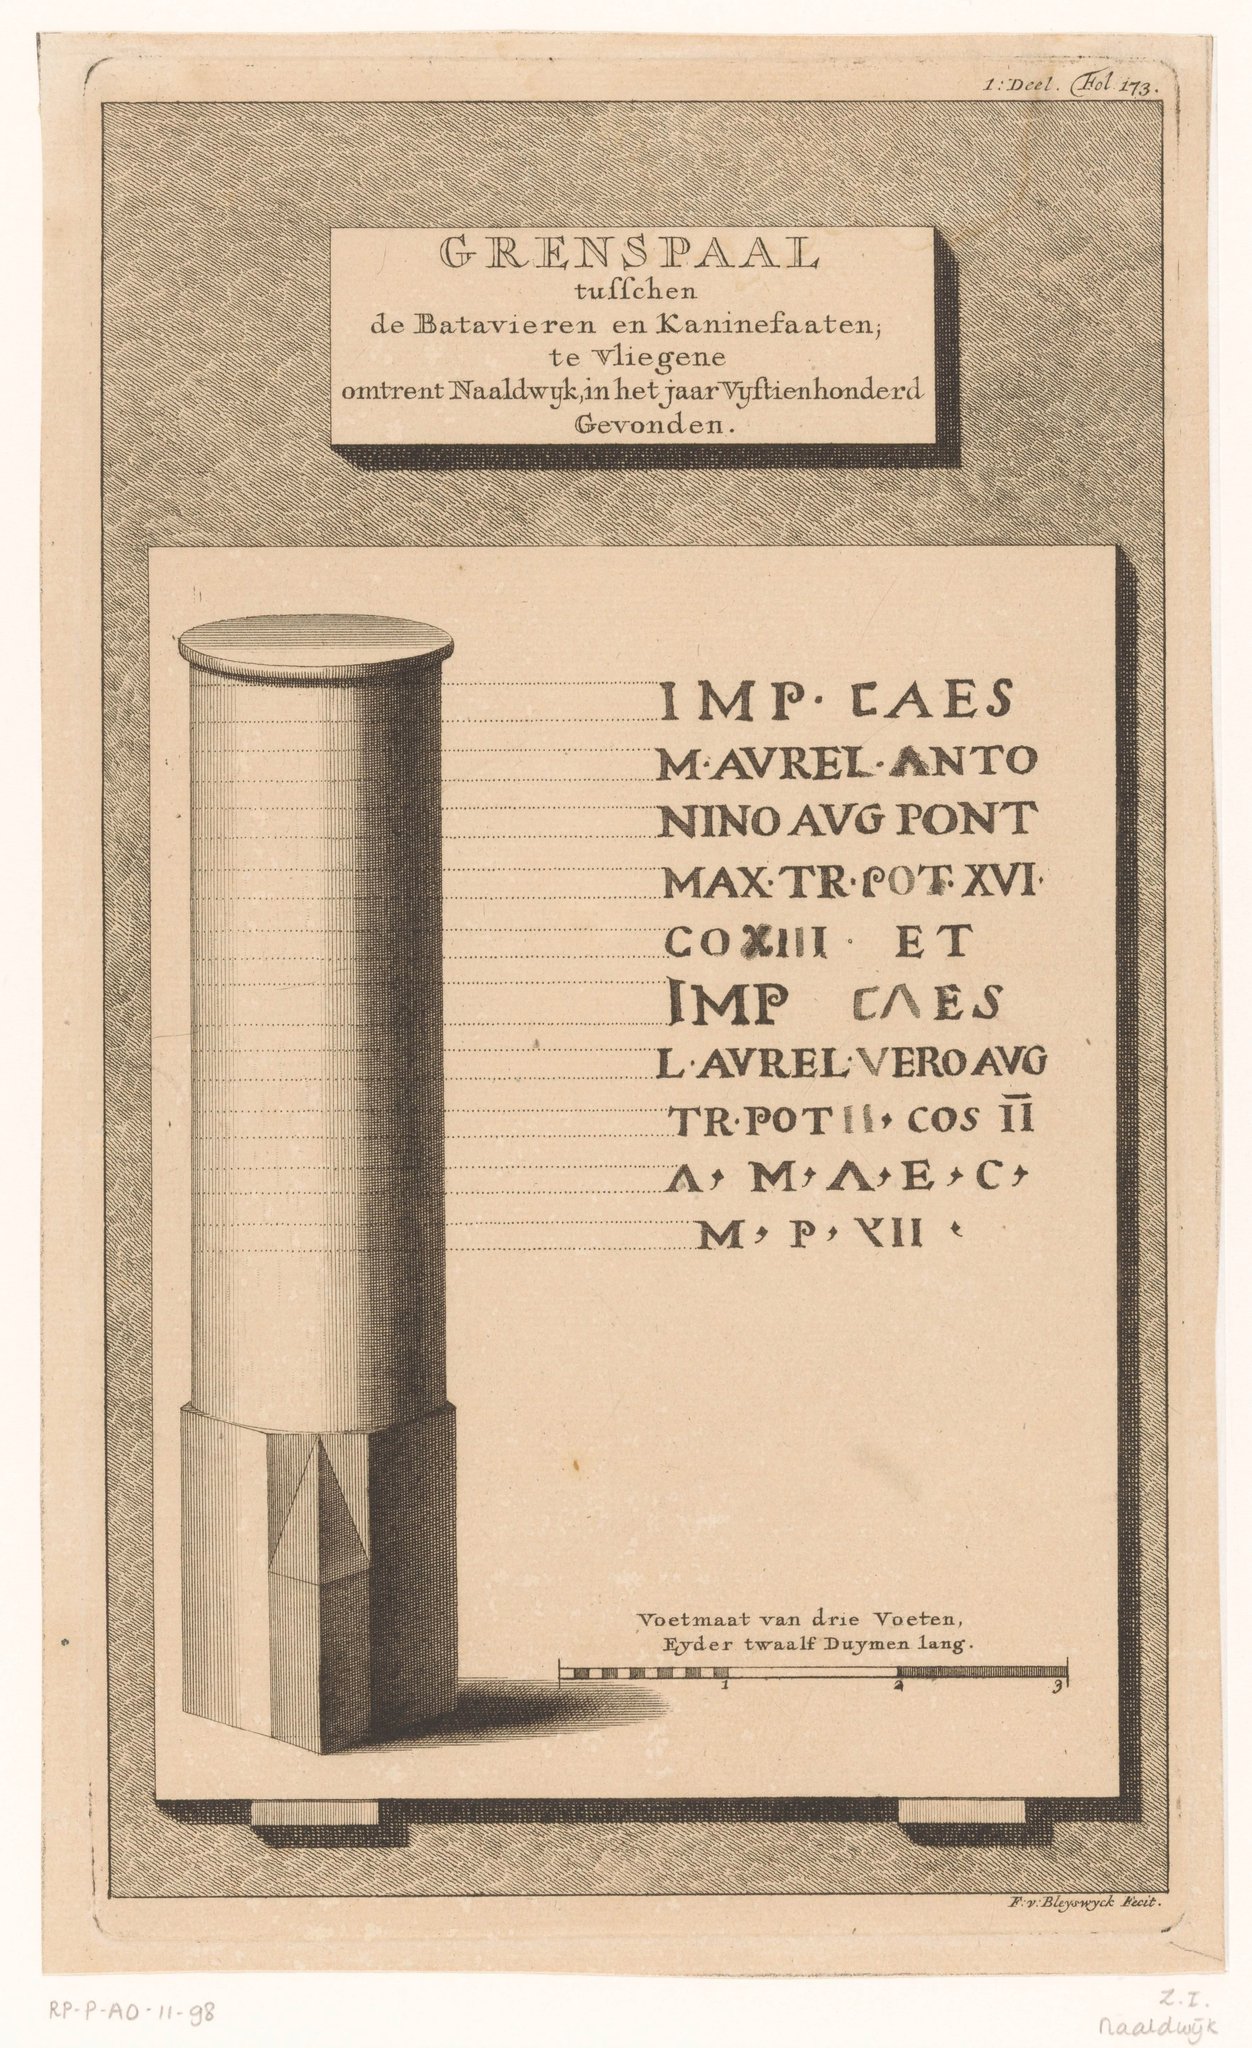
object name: historical object representation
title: Grenspaal tussen de Bataven en de Cananefaten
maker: françois van bleyswijck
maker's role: draughtsman, print maker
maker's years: 1671-1746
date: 1734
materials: paper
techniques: engraving, etching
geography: leiden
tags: boundary-post, boundary-stone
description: Prent gebruikt in: Loon, Gerard van. Aloude Hollandsche histori der keyzeren, koningen, hertogen en graaven; welken, sedert de komst der Batavieren in het thans genaamde Holland, tot de herstelling van 's graaven Florents den eerstens zoon, aldaar het hooggebied gehad hebben (…). 2 delen. Den Haag: Pieter de Hondt, 1734, deel 1, fol. 173.